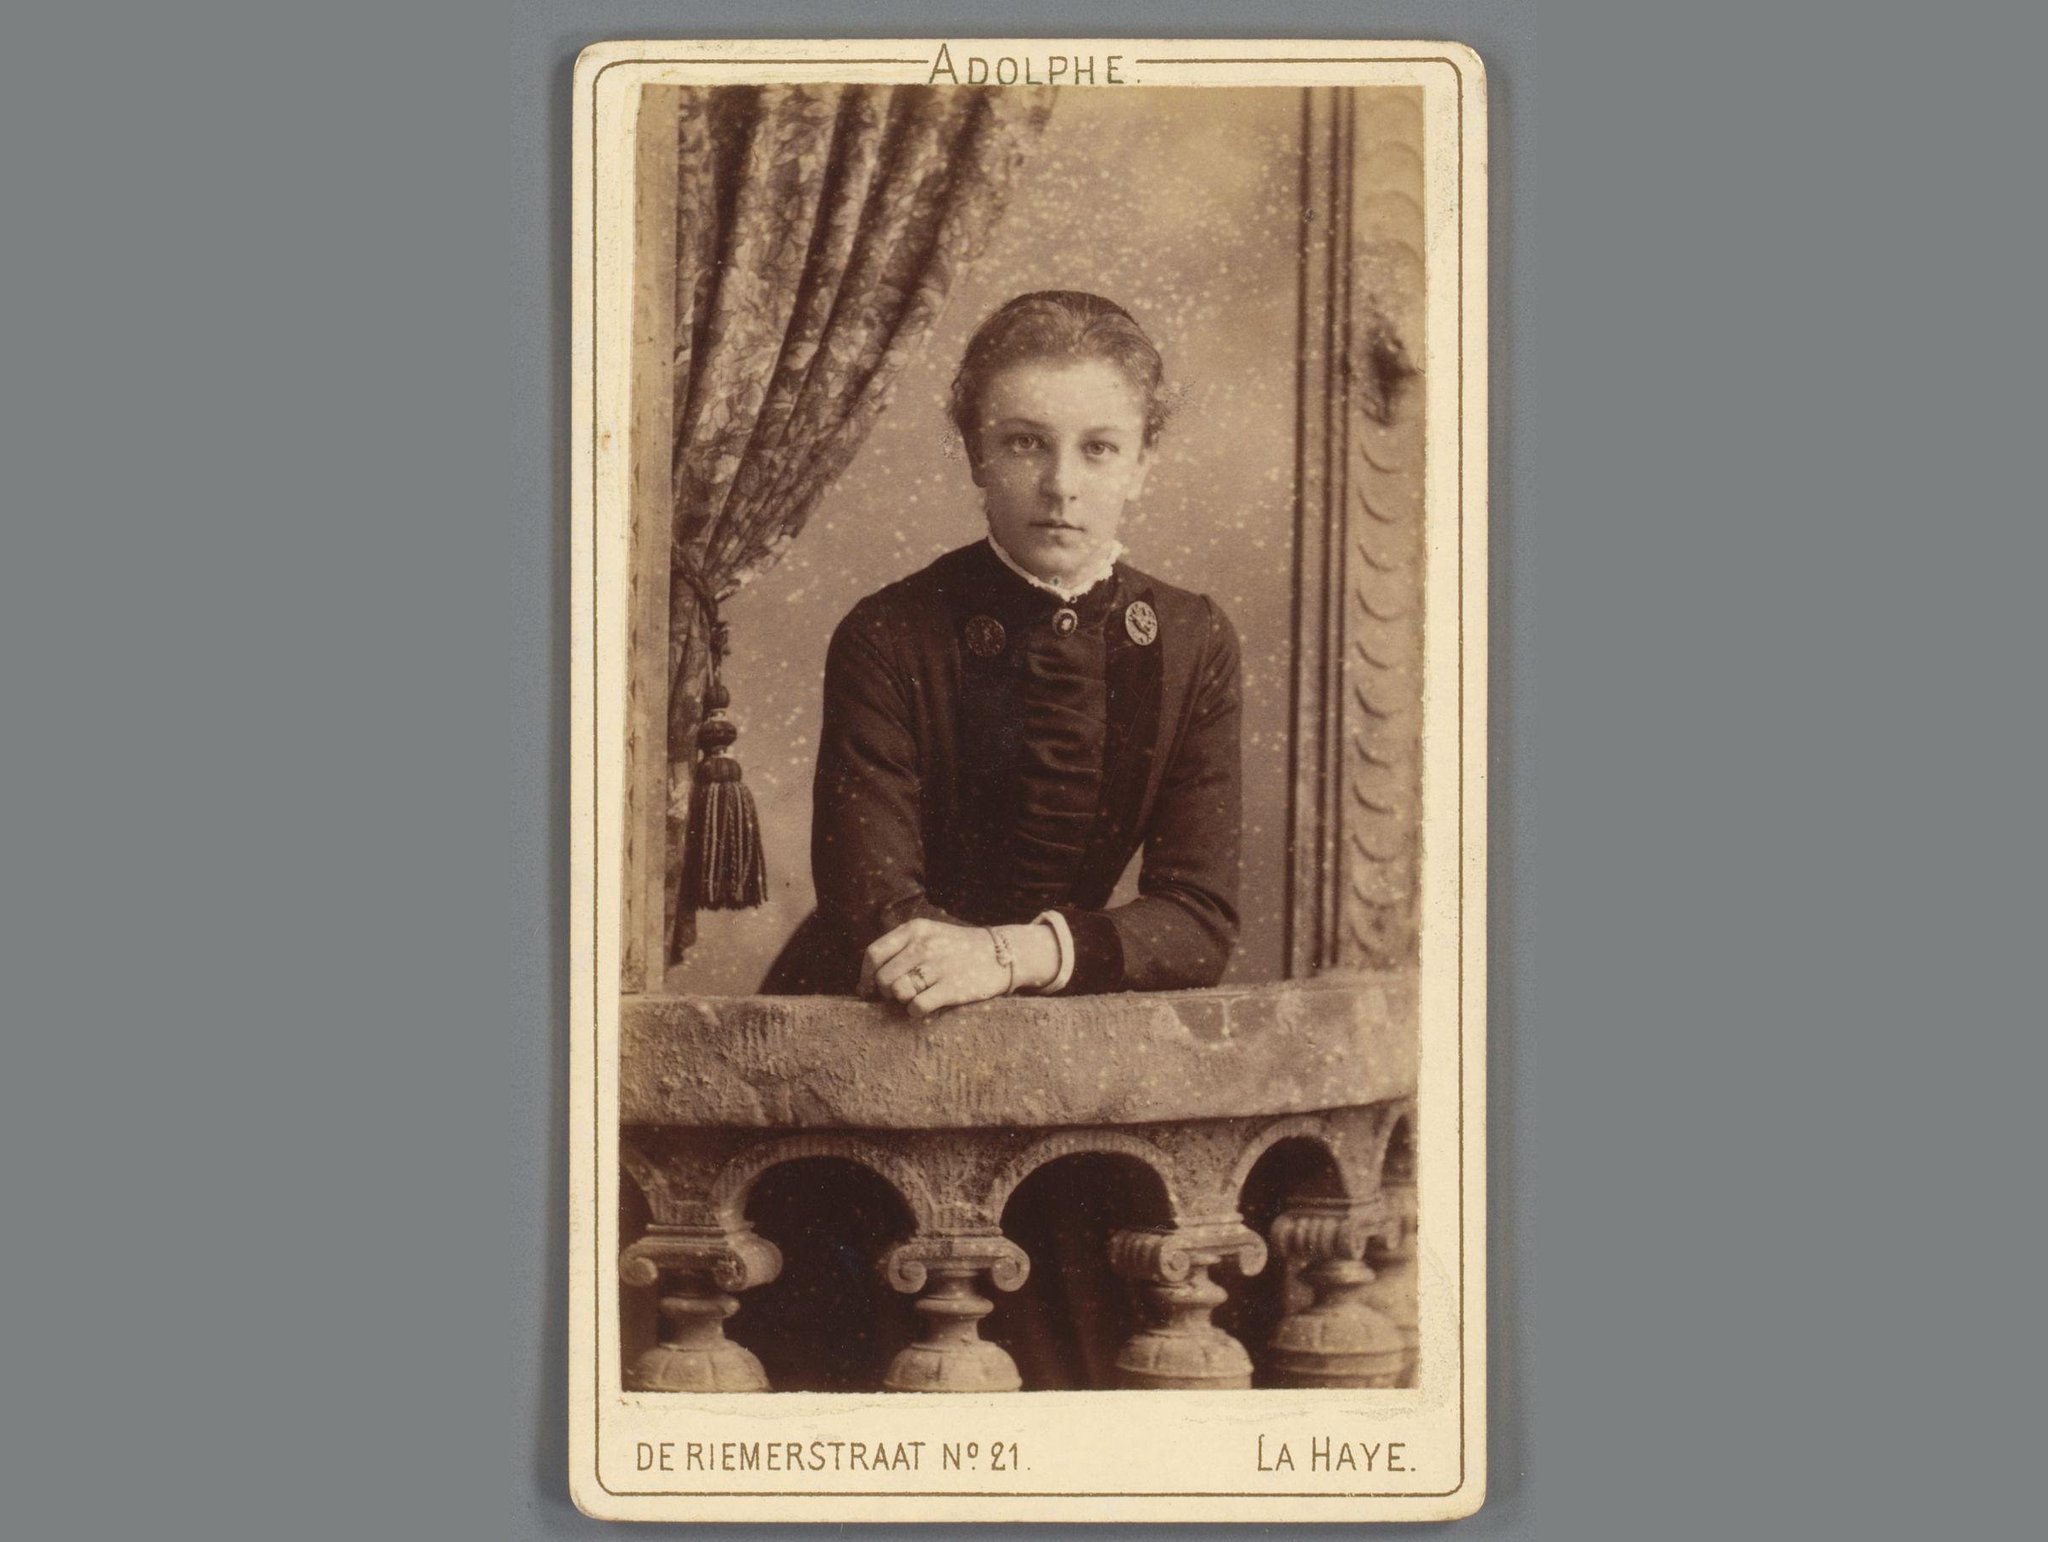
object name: carte de visite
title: Portret van een onbekende vrouw, mogelijk een lid van de familie Onnen-van den Berg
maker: adolphe zimmermans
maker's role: fotograaf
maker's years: 1858-1922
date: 1884-1892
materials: cardboard, paper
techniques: albumen print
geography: the hague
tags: anonymous historical person portrayed - bb - woman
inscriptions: address: ‘De Riemerstraat No 21./ La Haye.’